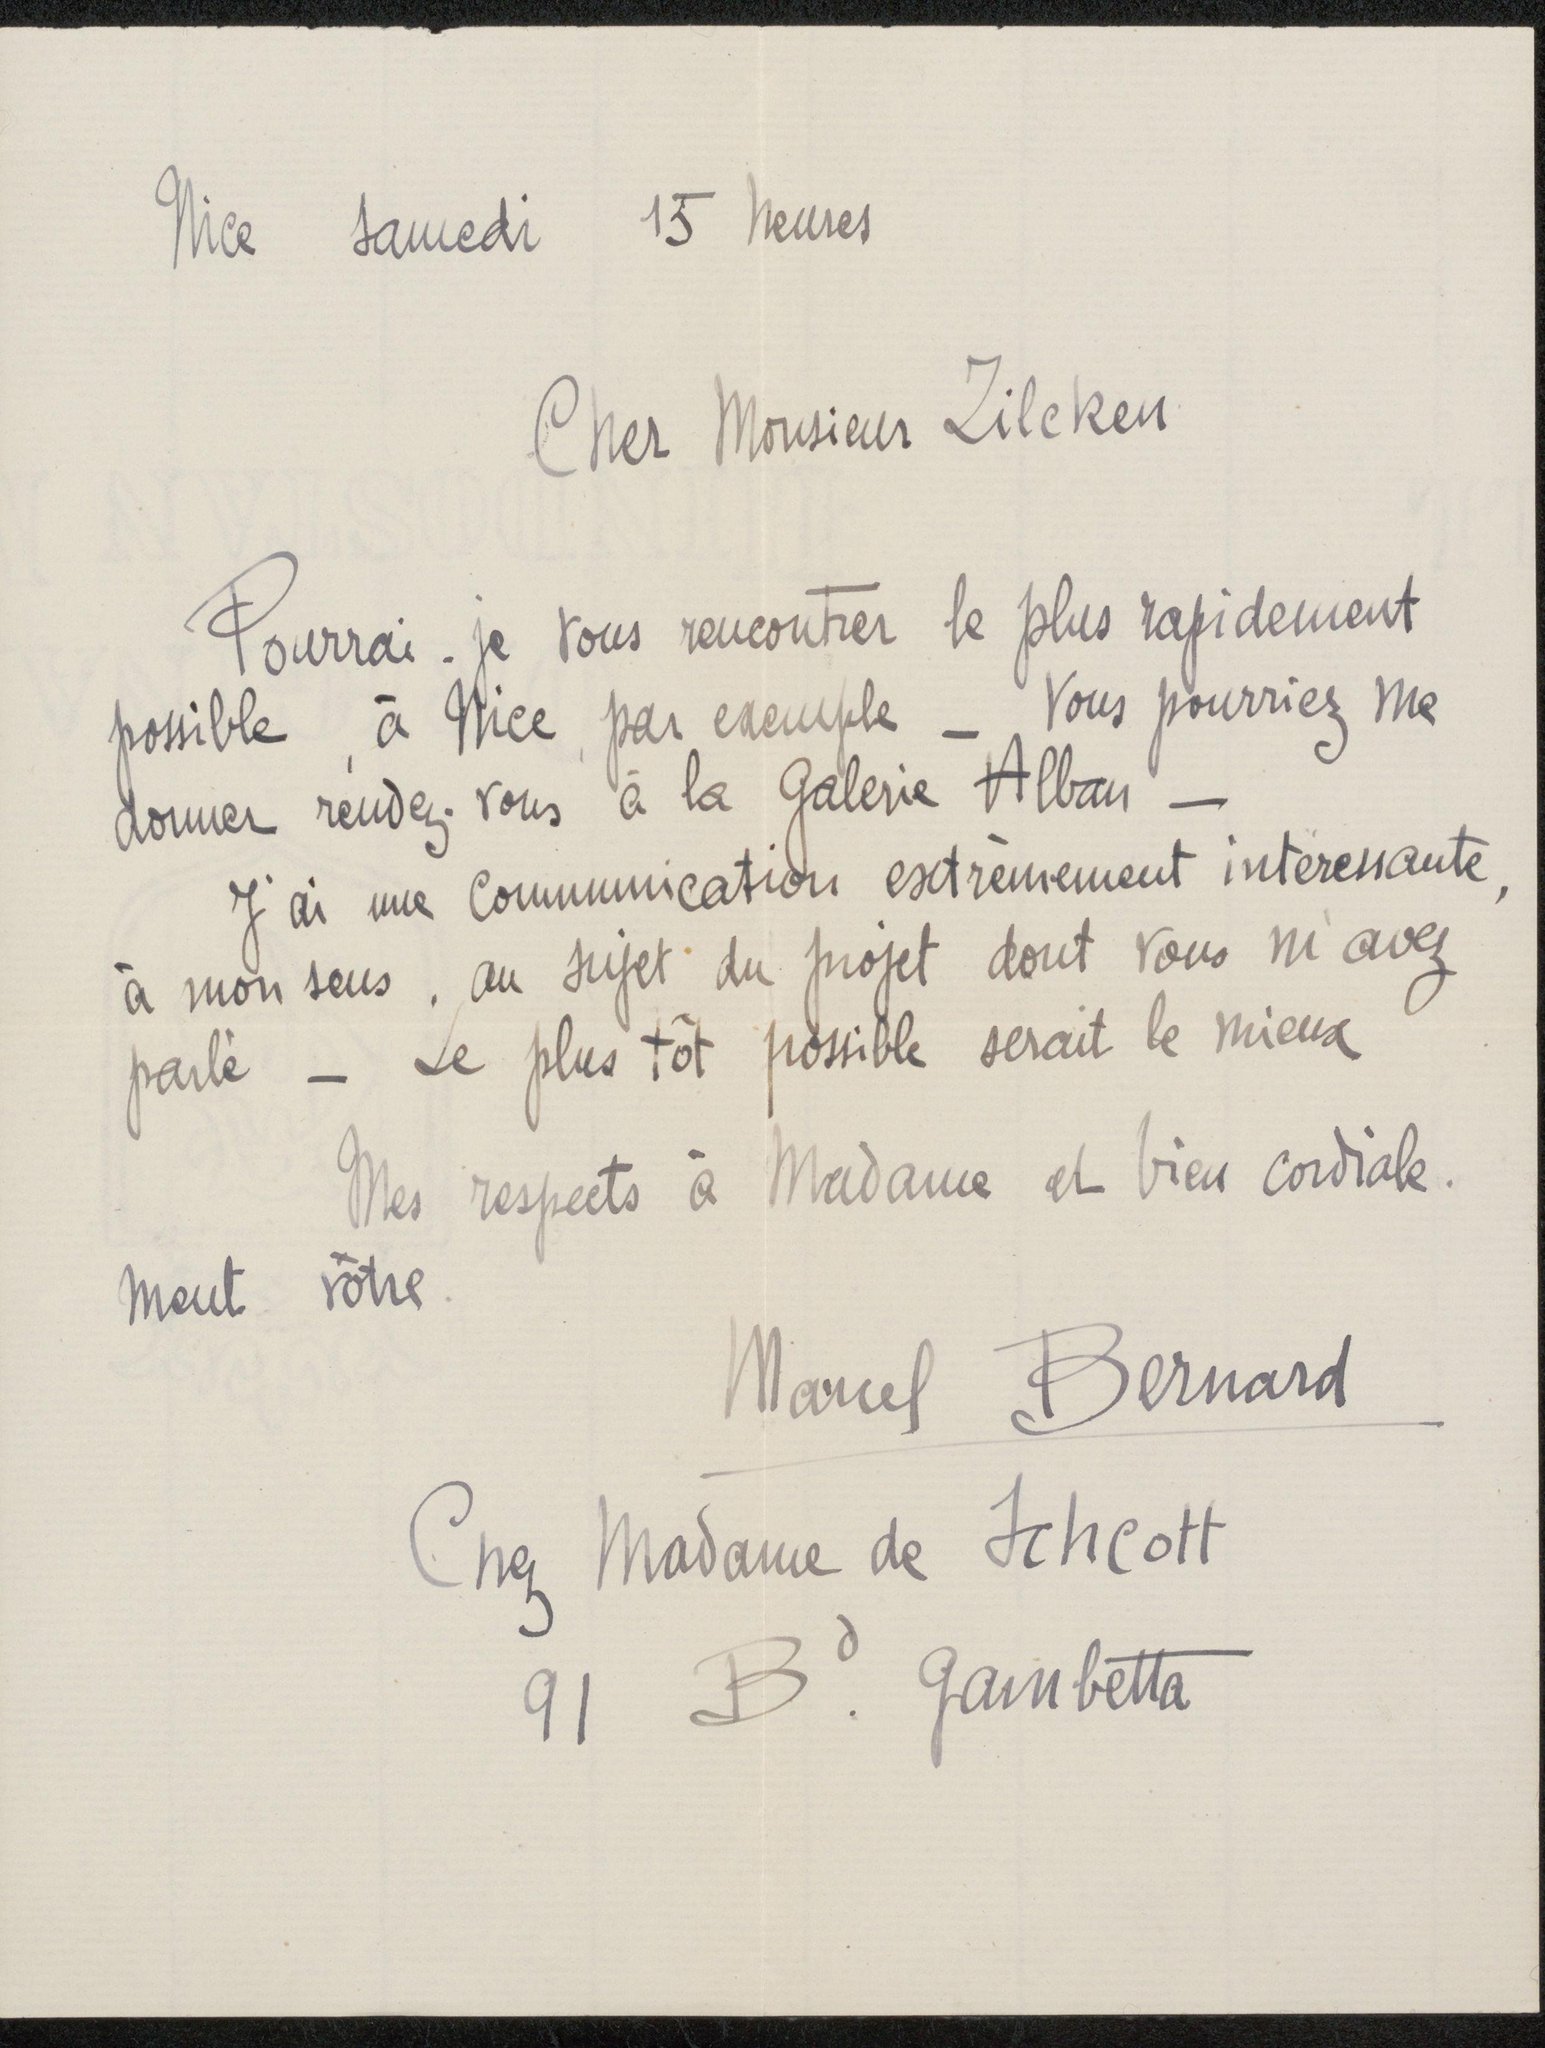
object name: letter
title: Brief aan Philip Zilcken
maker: marcel bernard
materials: ink, paper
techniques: pen, writing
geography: nice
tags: the hague, painter, draughtsman, philip zilcken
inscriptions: collector's mark: ‘RPK’